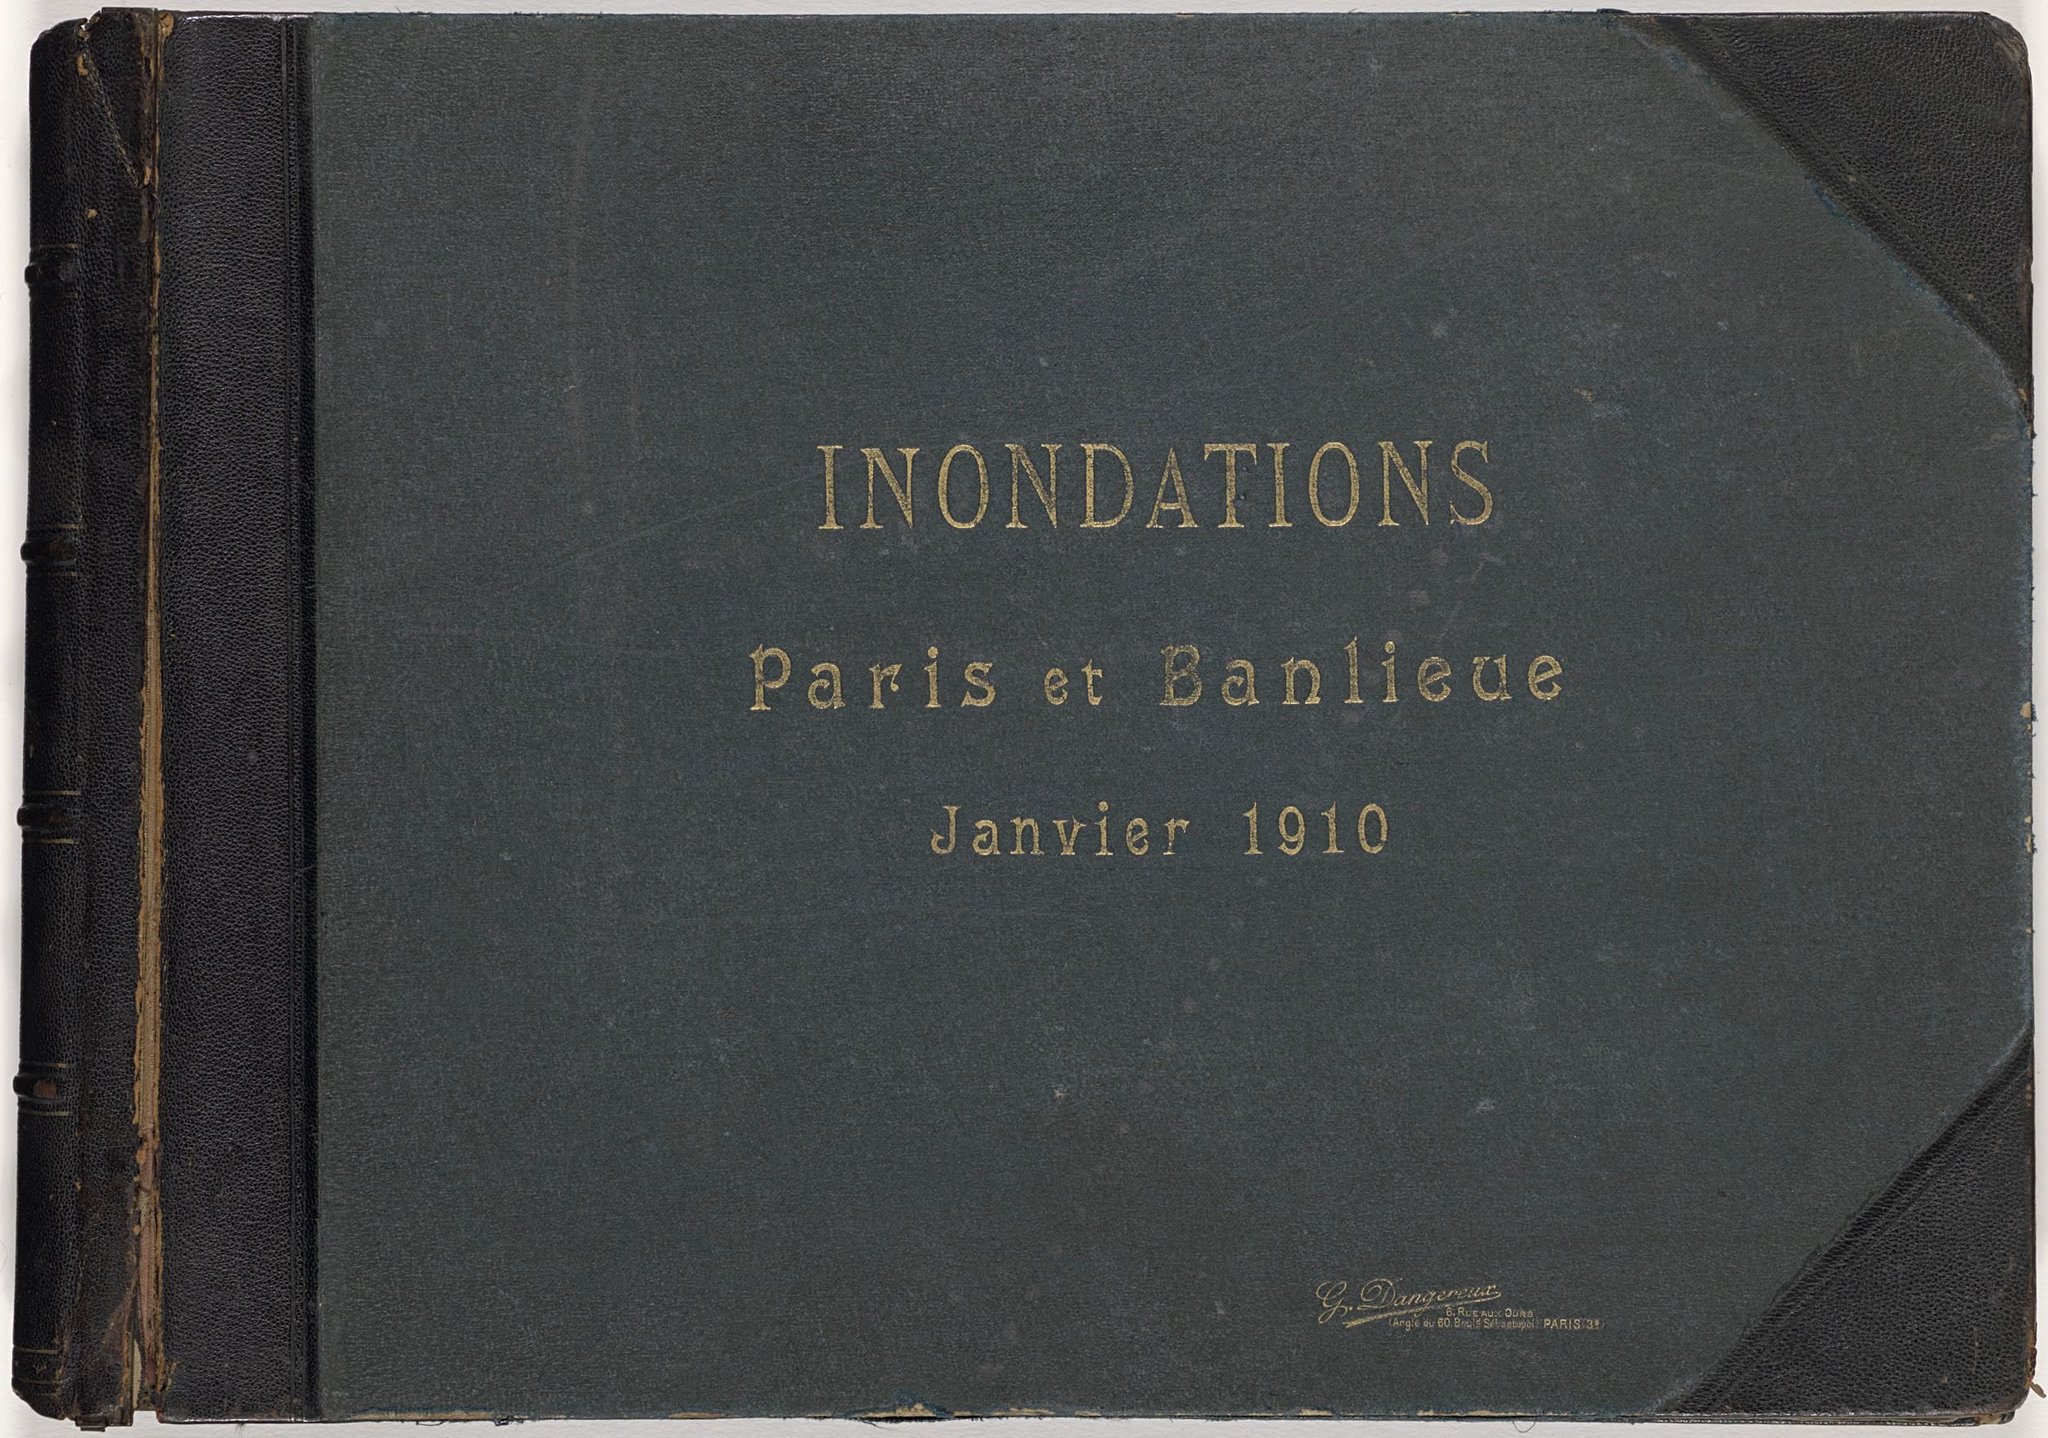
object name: photograph album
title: INONDATIONS Paris et Banlieue Janvier 1910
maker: g. dangereux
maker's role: fotograaf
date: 1901-1910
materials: cardboard, leather, metal, paper, photographic support, textile, wood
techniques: matte daylight collodion silver print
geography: paris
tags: flood, paris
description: Album met donkergroene kaft met goudkleurig opschrift. Rechtsonder de naam en het adres van de fotograaf: G. Dangereux 6. Rue aux Ours (Angle du 60. Bould. Sébastopol) PARIS (3e). De rug is aan de binnenkant verstevigd met hout en metaal. Metalen pennen houden de bladen bij elkaar. De hoekpunten van het omslag aan voor- en achterzijde zijn van leer. De schutbladen hebben een marmermotief. Op in totaal 16 donkergroene bladen zijn 67 foto's geplakt, veelal enkele kleine rondom een groter formaat. De laatste 6 bladen bevatten elk slechts één foto. Elke foto is op een goudkleurig vel papier geplakt, waardoor een rand rondom de foto ontstaat. De foto's betreffen de overstroming van Parijs en haar voorsteden in januari 1910, toen de Seine na overvloedige regenval buiten haar oevers trad en het openbare leven ontwricht werd.